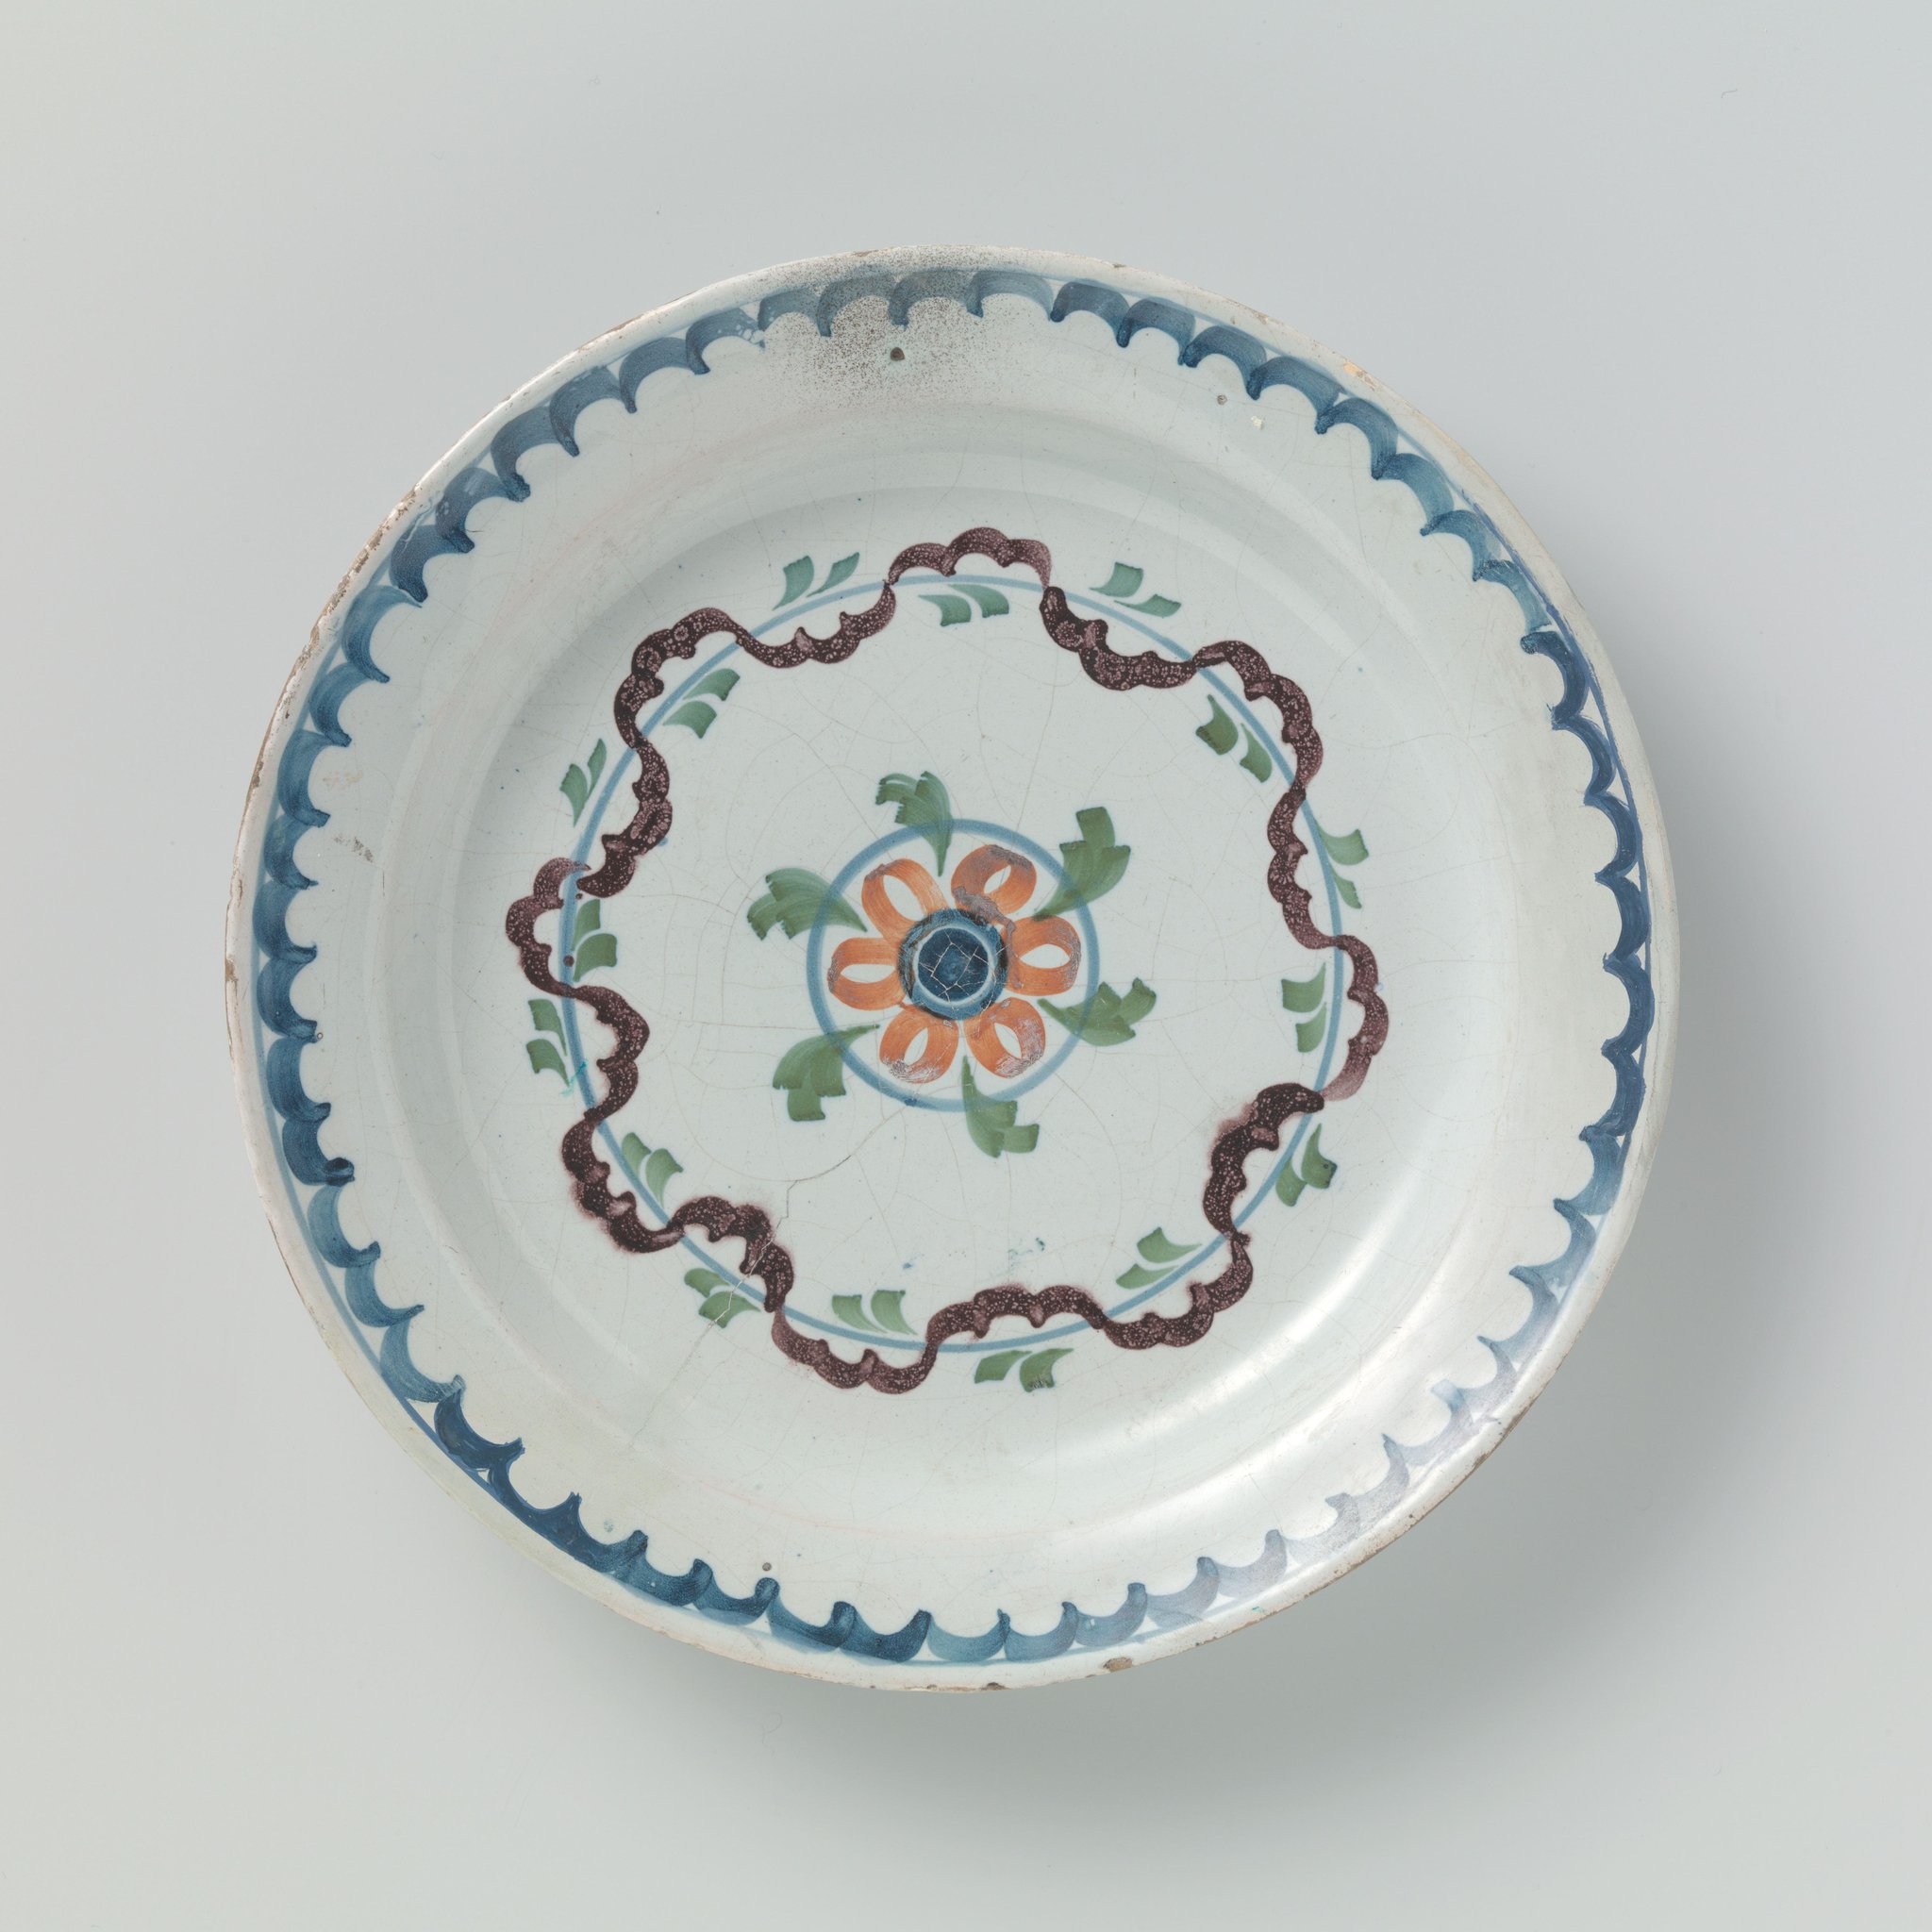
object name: plate dish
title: Bord van aardewerk versierd met geometrische ornamenten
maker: Anonymous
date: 1720-1760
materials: earthenware, glaze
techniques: painted, polychromy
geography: lambeth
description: Rond bord van veelkleurig faience versierd met geometrische ornamenten op het plat en langs de rand. De versiering is in de kleuren blauw, paars, groen en bruin.